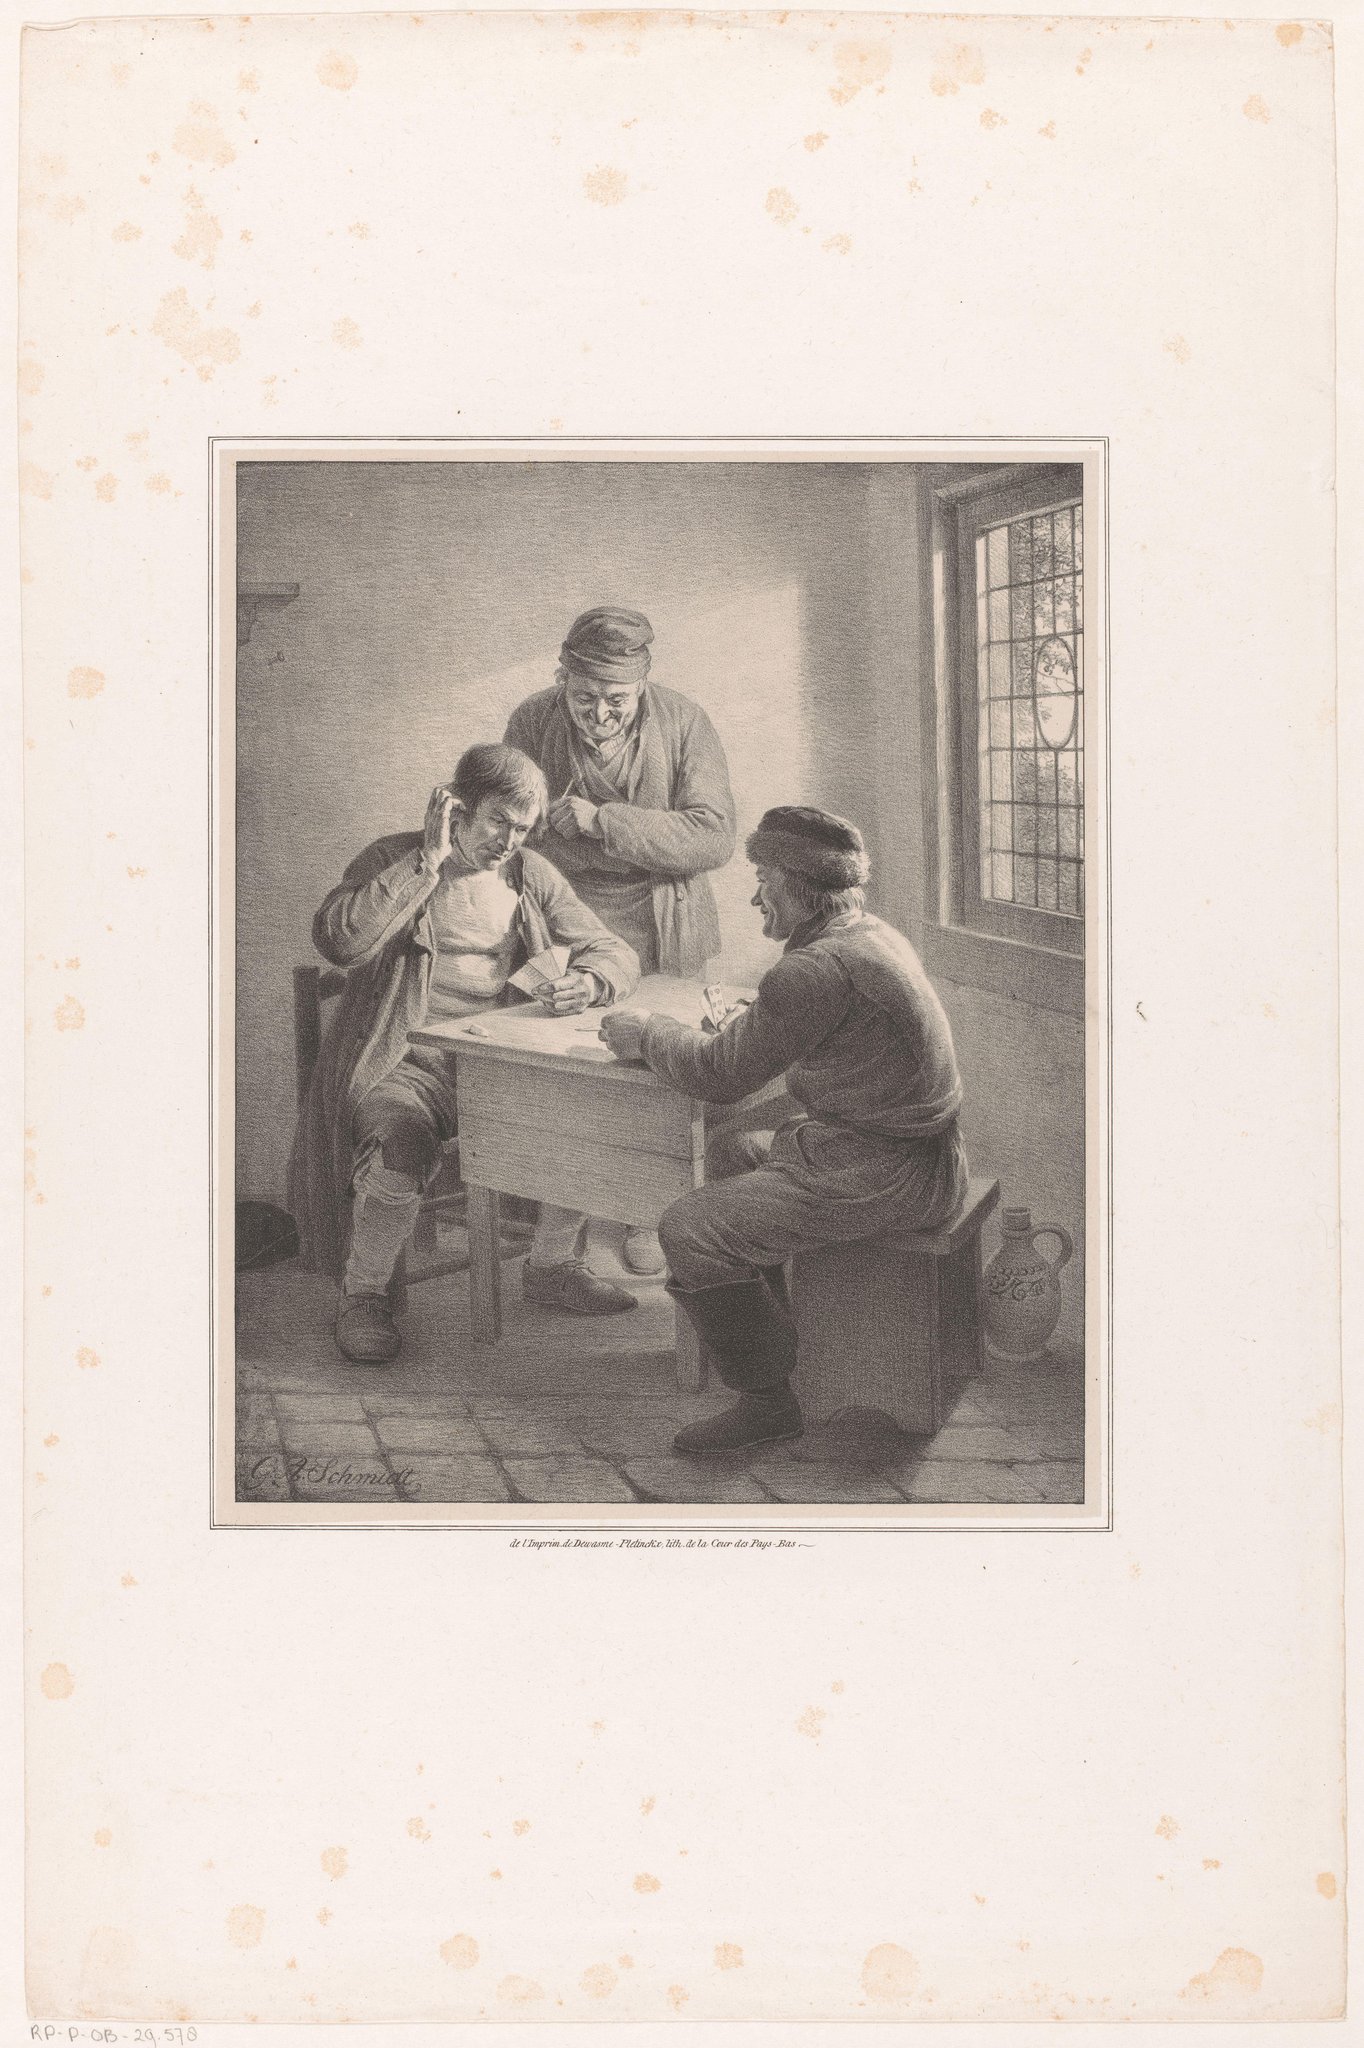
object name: print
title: Kaartspelende mannen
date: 1812-1844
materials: paper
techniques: lithograph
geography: brussels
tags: card games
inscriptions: collector's mark: Lugt 2228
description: Twee mannen zitten aan tafel en spelen een kaartspel. Een derde man met pijp in de hand kijkt naar het tweetal.